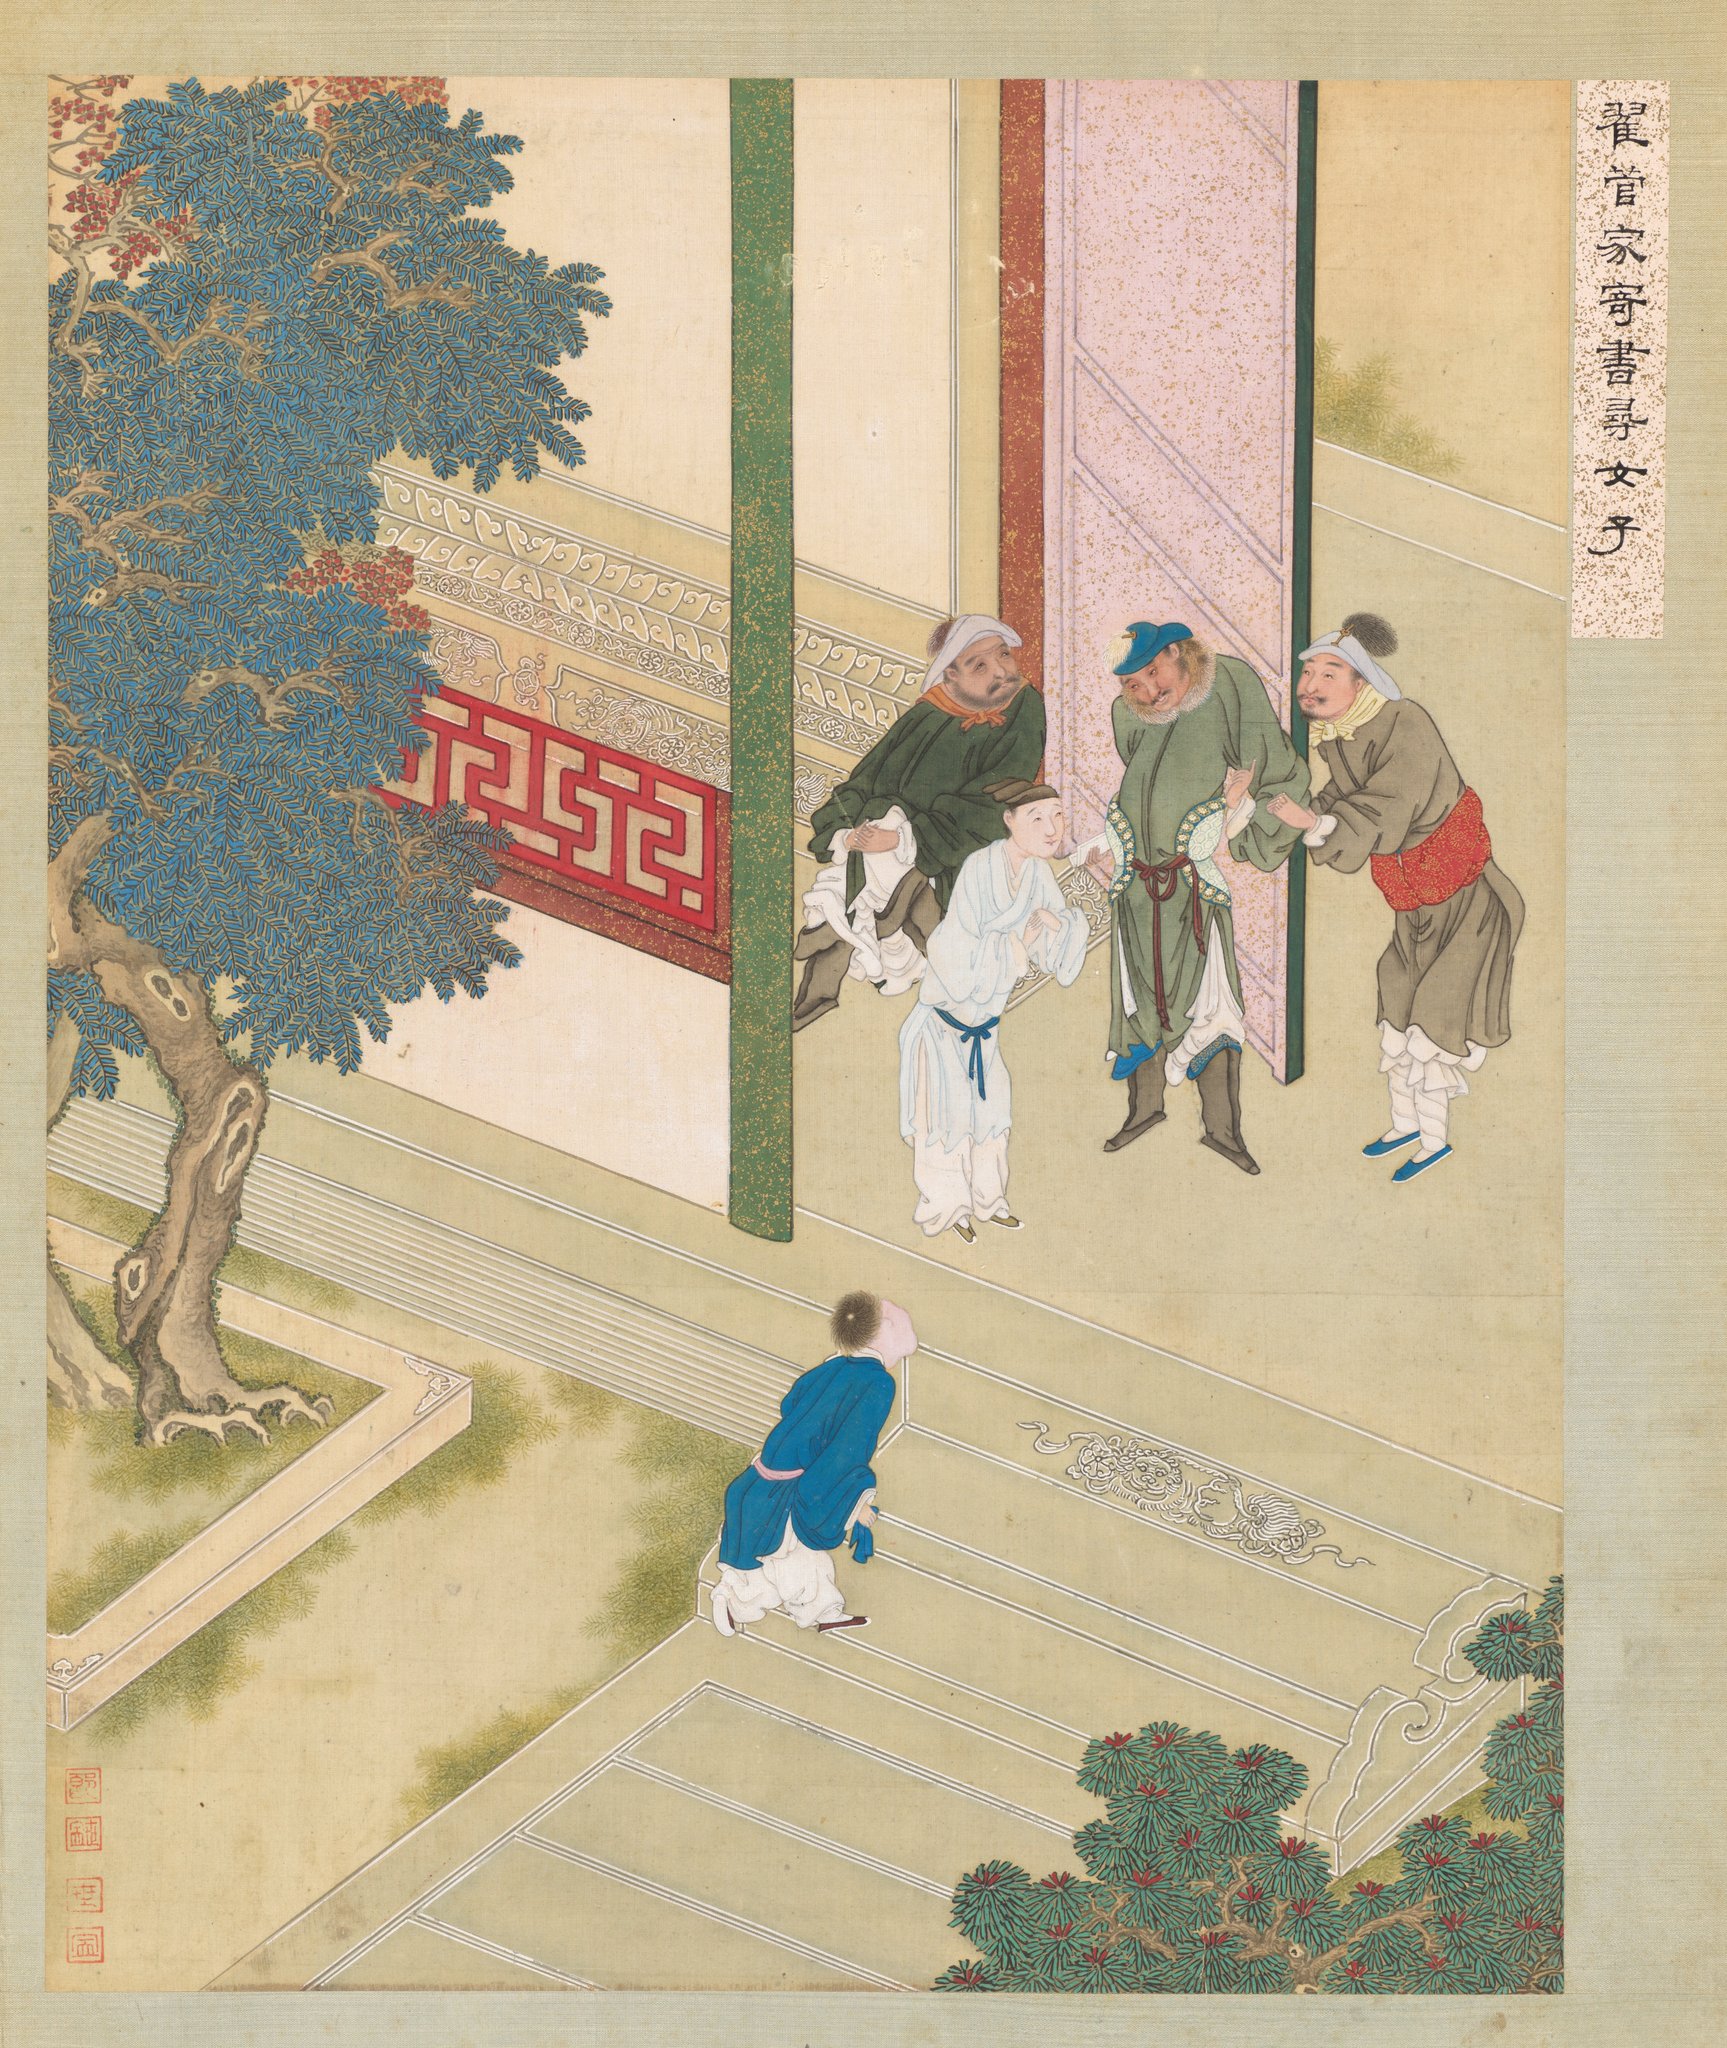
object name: album leaf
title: Scenes from the Plum in the Golden Vase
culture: chinese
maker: gu jianlong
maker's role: artist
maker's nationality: chinese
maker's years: 1606-1687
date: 1667-1733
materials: ink, silk